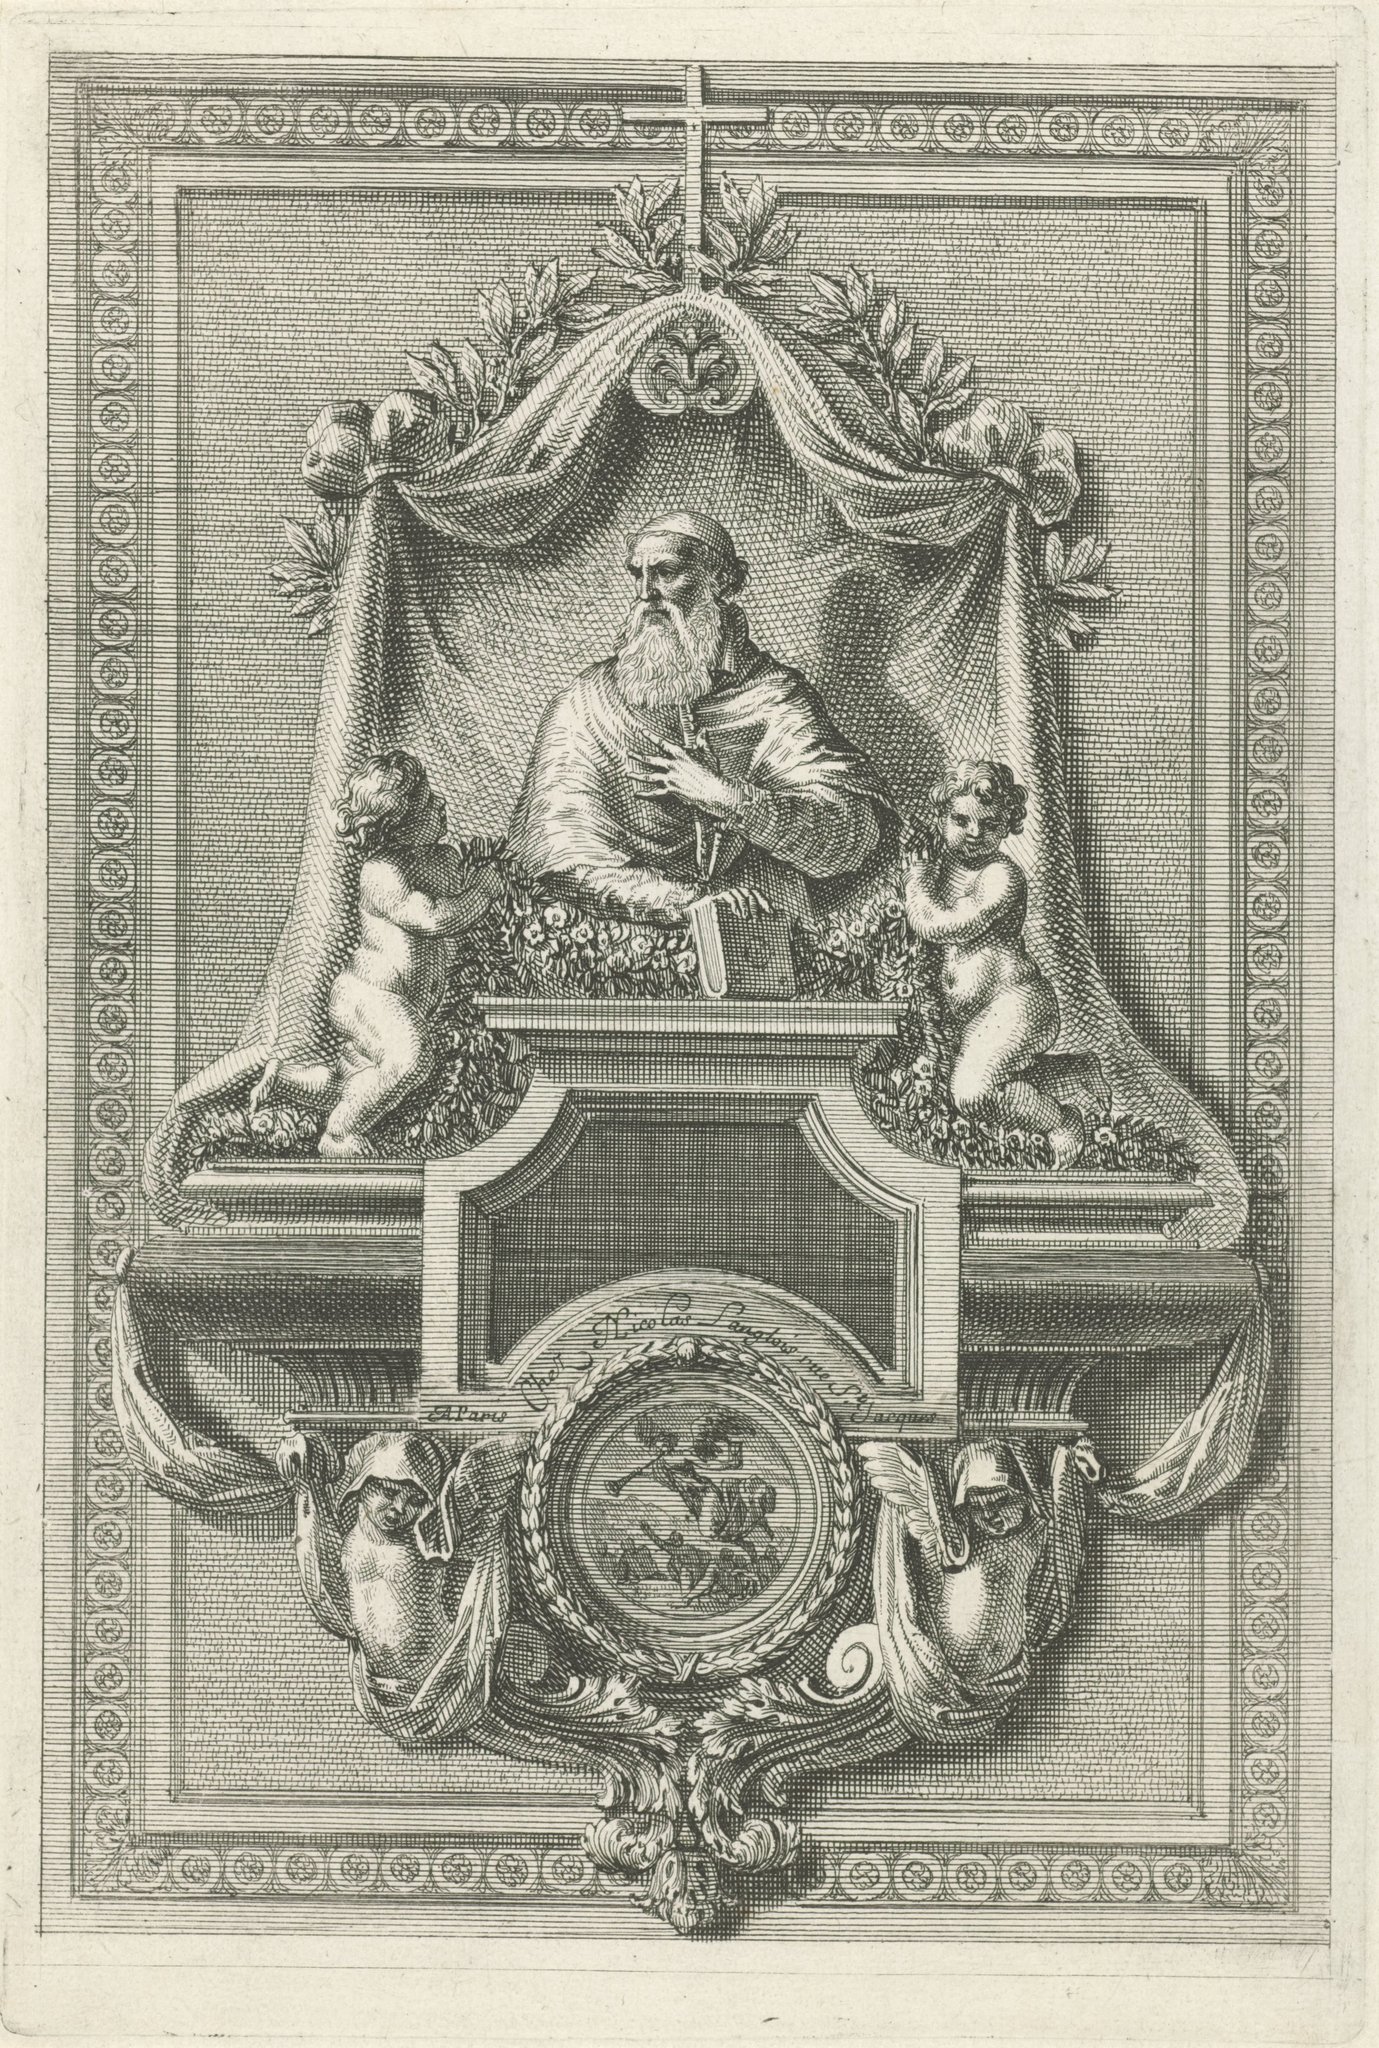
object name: print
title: Sepultures et Epitaphes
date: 1691-1703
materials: paper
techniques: etching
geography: france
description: Met leeg tablet, boven de kist staat een buste van een priester geflankeerd door twee putti. Uit serie van 6 bladen, tweede editie.